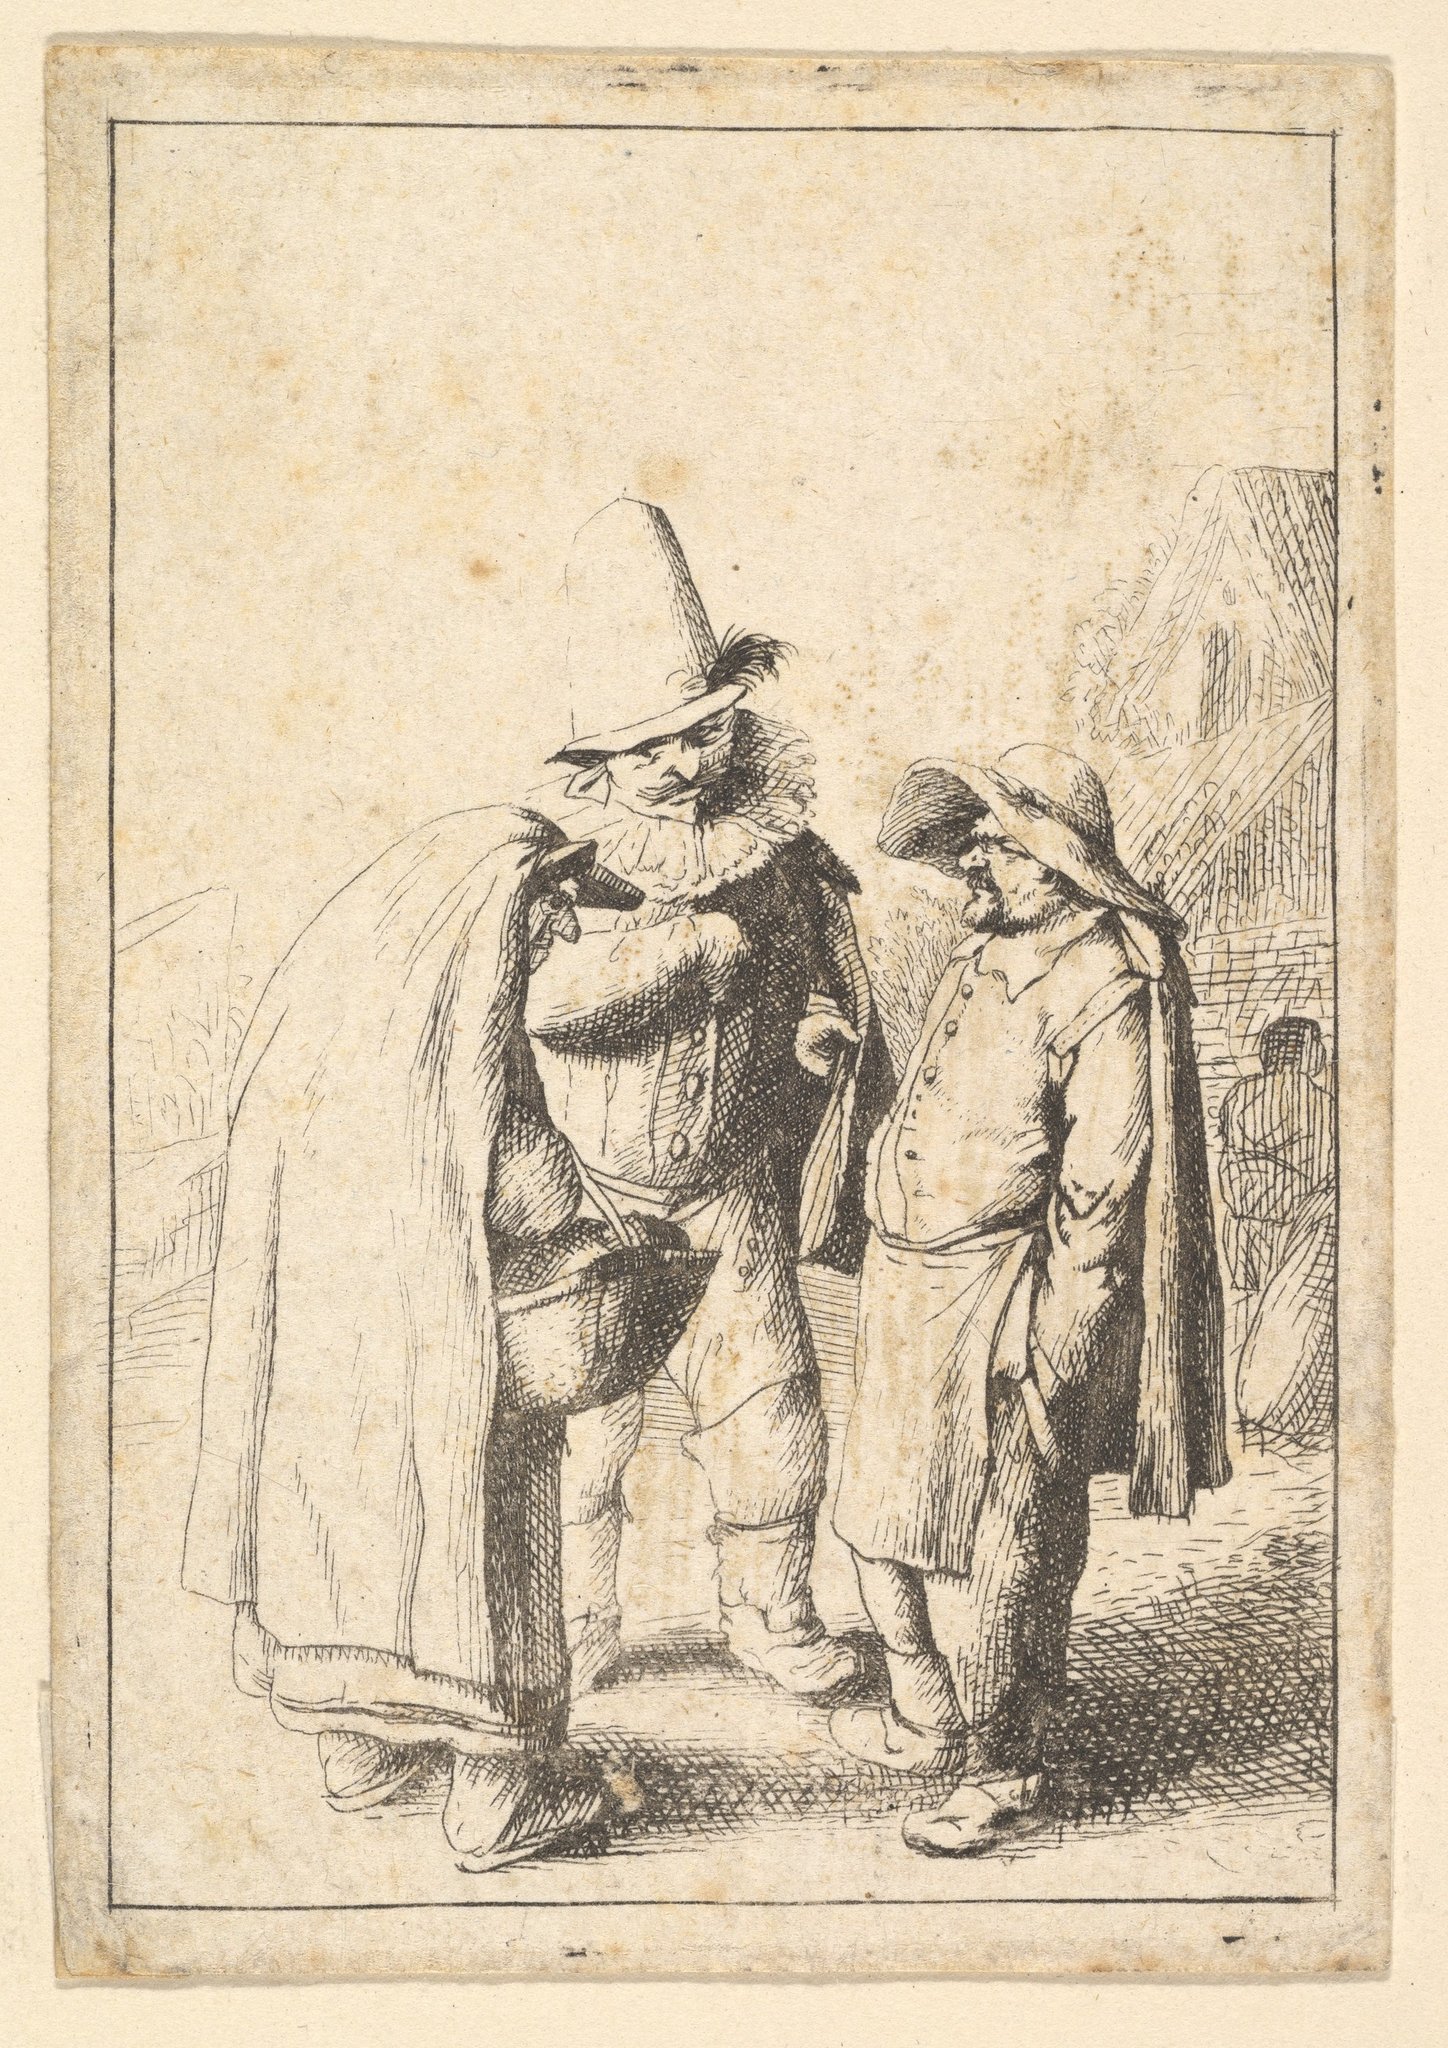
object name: print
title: Grotesque Figures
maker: adriaen van ostade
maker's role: artist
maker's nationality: dutch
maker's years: 1610-1685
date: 1610-1685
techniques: etching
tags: men